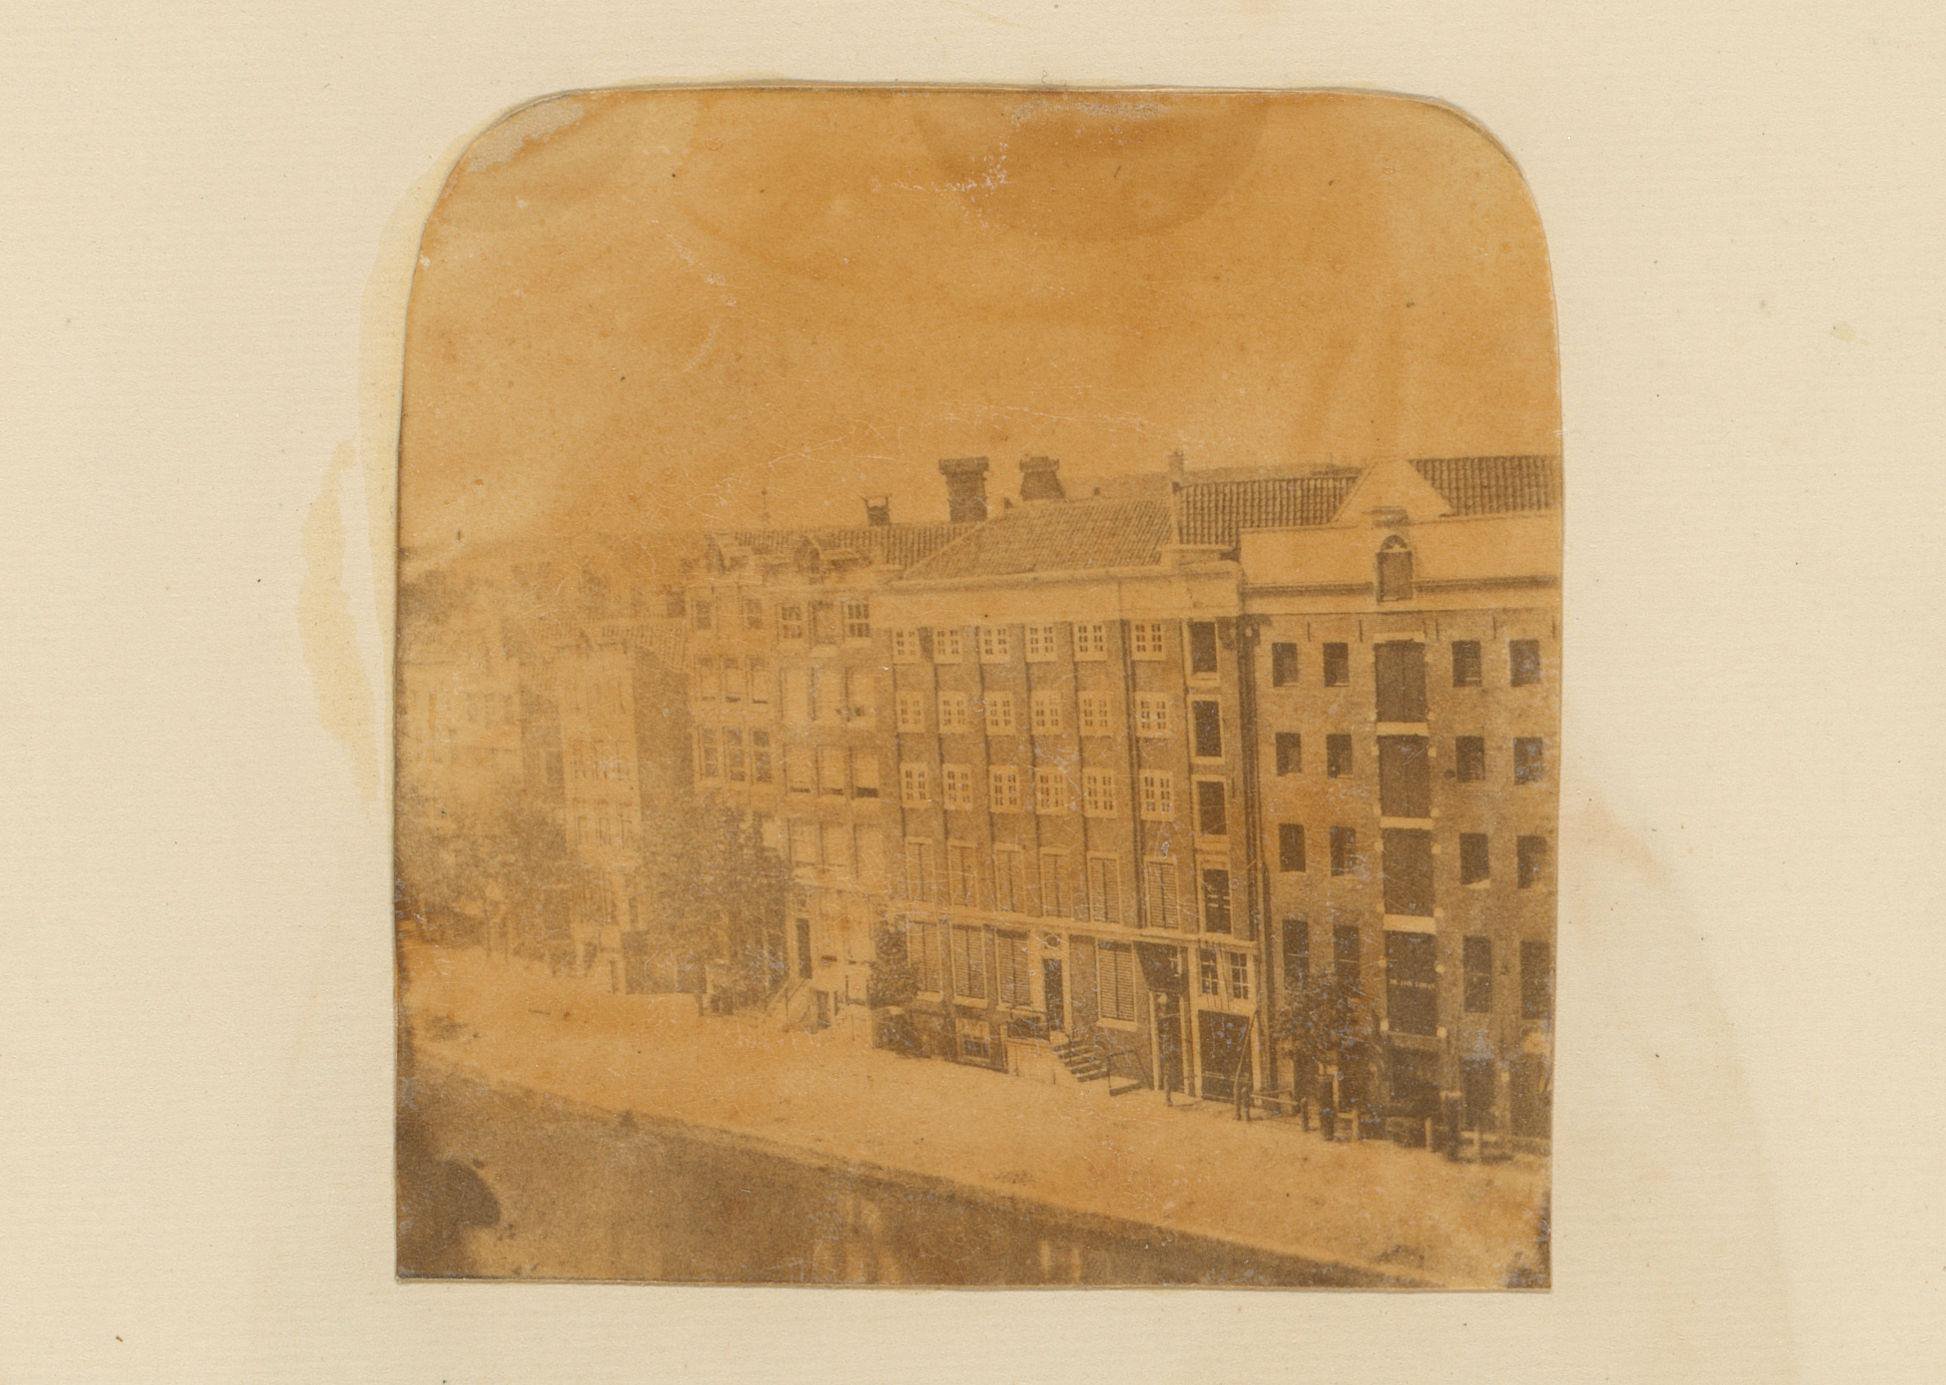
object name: photograph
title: Gezicht vanaf het dak van het huis van de fotograaf op het Singel, Amsterdam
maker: eduard isaac asser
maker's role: amateurfotograaf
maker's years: 1809-1894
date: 1852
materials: cardboard, paper, photographic support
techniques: salted paper print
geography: amsterdam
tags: singel